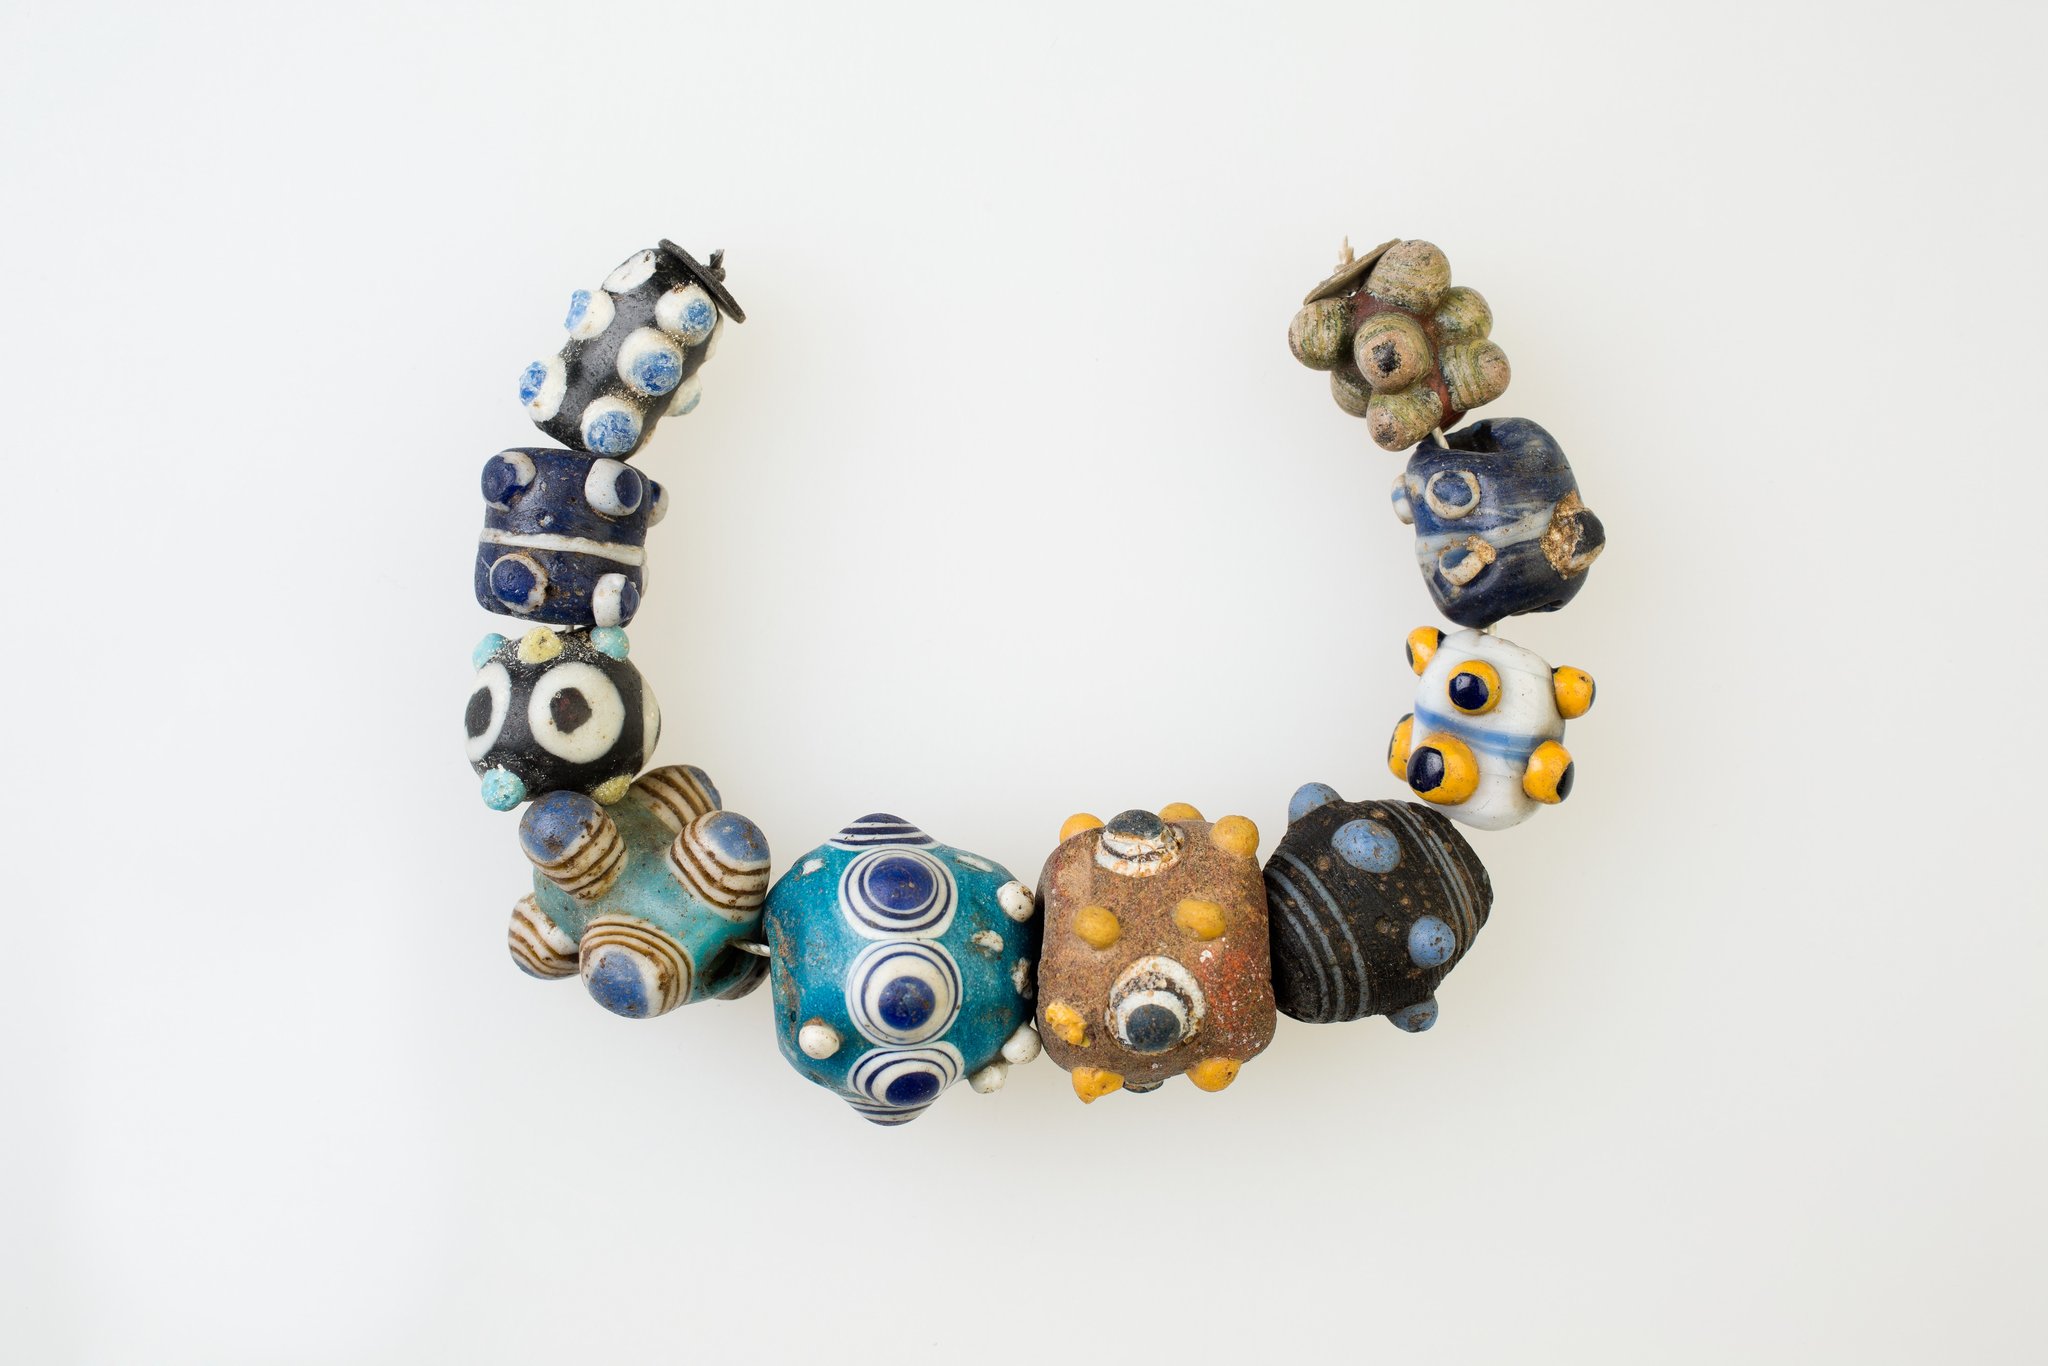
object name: bead, string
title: String of 10 Beads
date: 400-200 BCE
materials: glass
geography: egypt